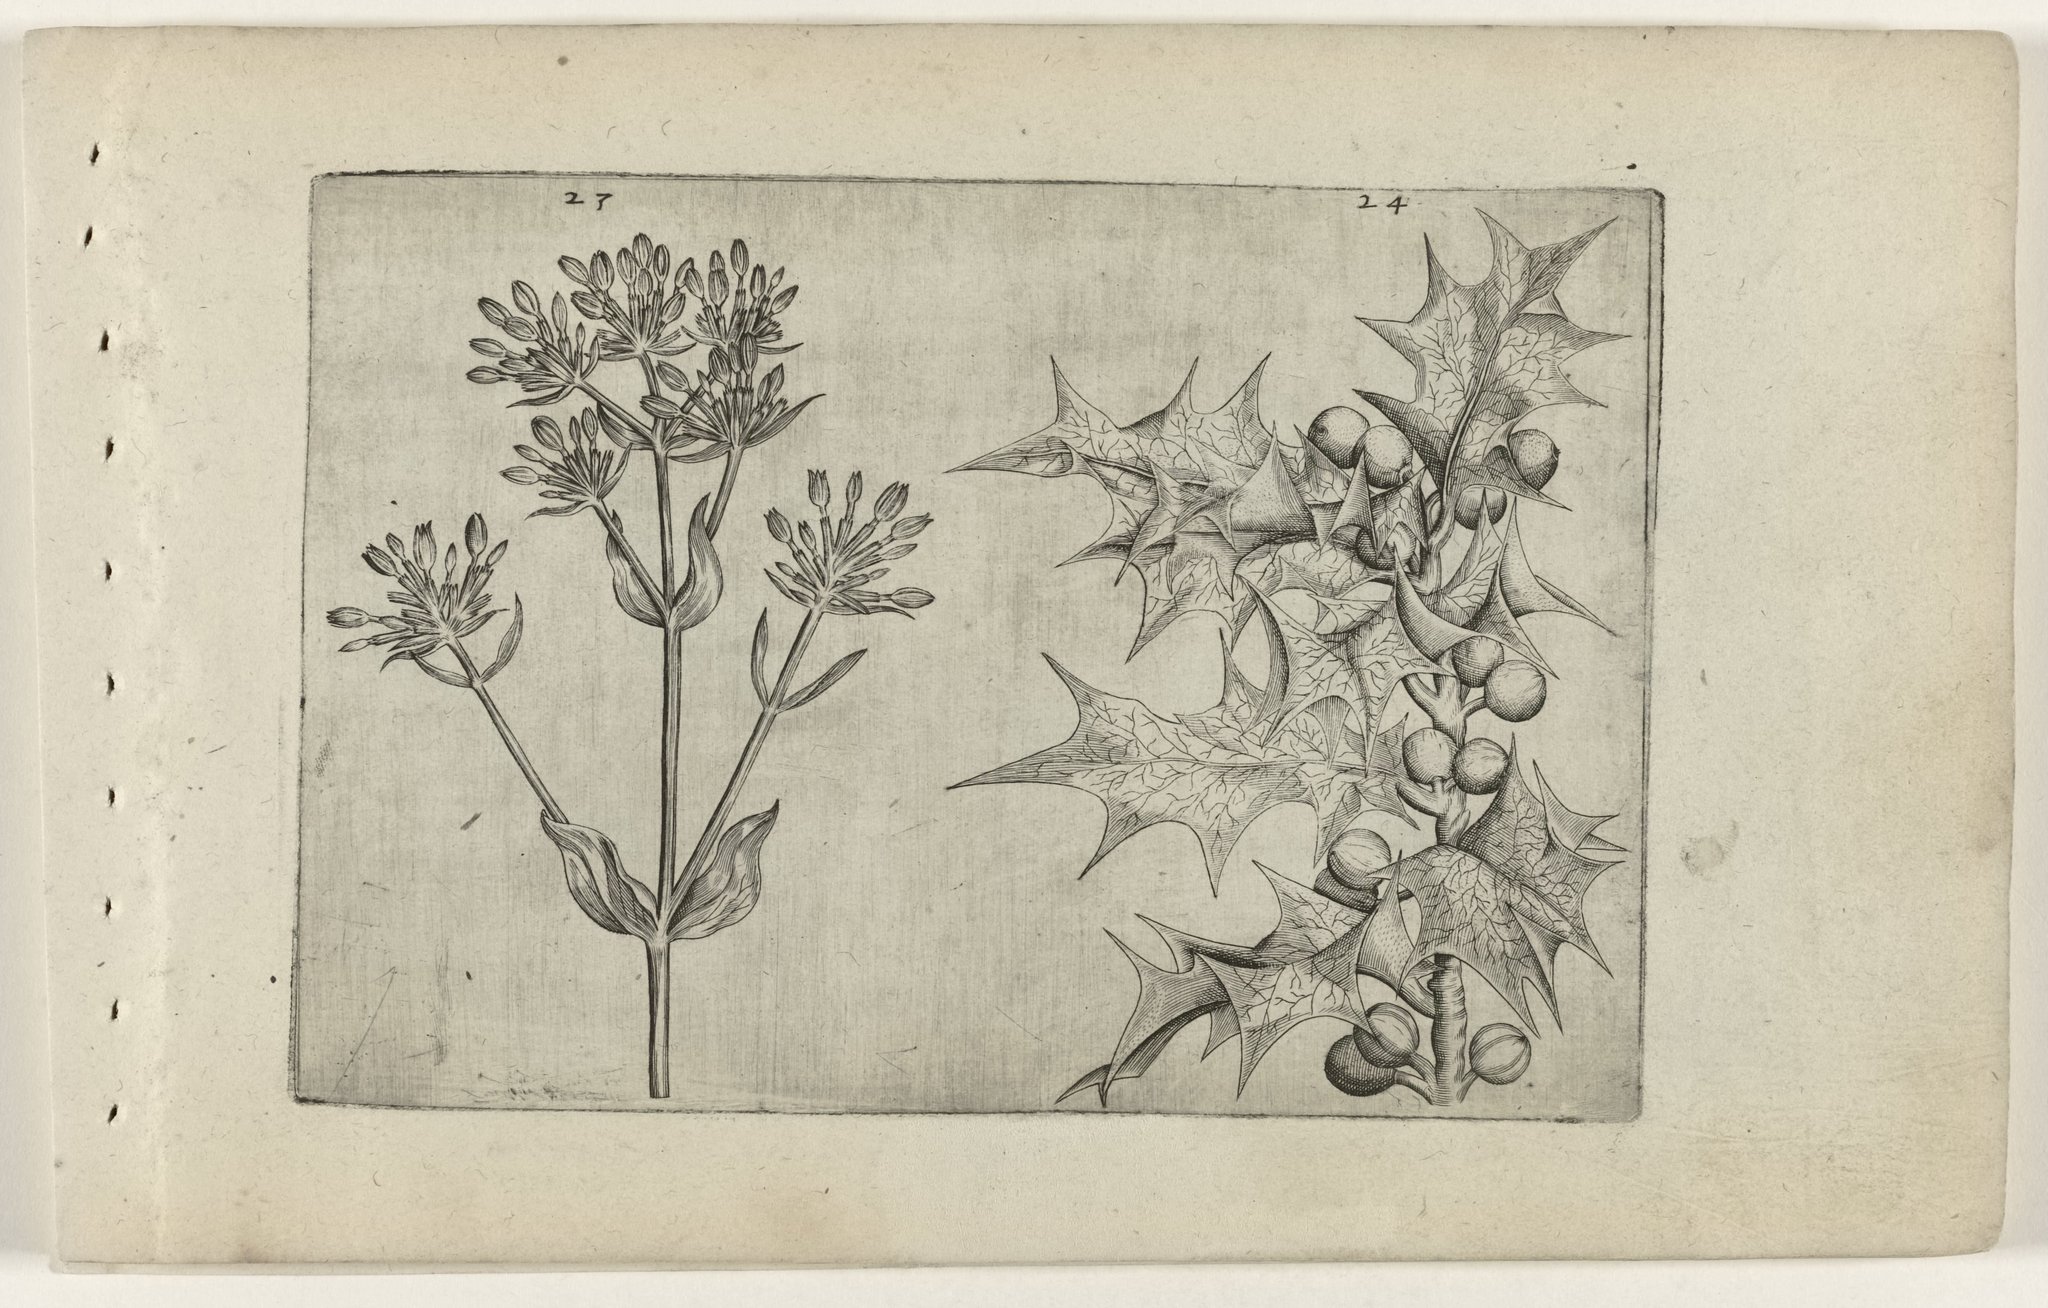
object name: print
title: Cognoscite lilia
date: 1600-1604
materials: paper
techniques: engraving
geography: london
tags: plants and herbs: holly, flowers: centaurium, botany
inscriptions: collector's mark: Lugt 2228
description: De prenten RP-P-2012-24-1 t/m 61 waren oorspronkelijk als serie samengebonden. De naaigaten op de bladen zijn nog zichtbaar. Het betreft de reeks getiteld: Cognoscite lilia, bestaande uit een titelprent en 60 gravures met 119 genummerde weergaven van planten, bloemen en vruchten, versierd met rinceaux en kleine voorstellingen van dieren. Het gaat om proefdrukken van deze reeks gravures, voor de opschriften en, deels, voor de nummering. Op enkele prenten zijn de nummers met de hand aangebracht. Op de titelprent ontbreekt nog het adres van Crispijn de Passe en Hans Woutneel. De titel is hoogstwaarschijnlijk gegraveerd door Matthias Quad. Deze werkte voor De Passe in Keulen tot 1604. De reeks moet in dit jaar of daarvoor tot stand zijn gebracht. In ieder geval voor 1608, aangezien de uitgever Hans Woutneel in of voor dat jaar overleed. In ieder geval voor 1608, aangezien de uitgever Hans Woutneel in of voor dat jaar overleed. De gravures worden door Ilja Veldman en Anthony Griffiths beschouwd als eigenhandig werk van Crispijn de Passe I. Een van de prenten uit de reeks ontbreekt (nr 21-22) en is vervangen door een ingekleurde afdruk uit een latere uitgave (RP-P-2012-24-61), die onder de titel Altera Pars is opgenomen in de Hortus Floridus, uitgegeven door Crispijn de Passe I en die verder bestaat uit platen van Crispijn de Passe II. De prenten afkomstig uit deze uitgave zijn op de verso voorzien van tekst in boekdruk. De vervangende prent maakte geen deel uit van de gebonden serie aangezien dit blad als enige geen naaigaten heeft. Een deel van de planten, bloemen en vruchten in de Cognoscite lilia gaat terug of is gebaseerd op een reeks aquarellen van Jacques LeMoyne uit circa 1580 en uit 1585, nu in het Victoria and Albert Museum en de British Museum (zie P. Hulton, Jacques LeMoyne, Londen 1977, dl 1, p. 156-162 en p. 165-173).